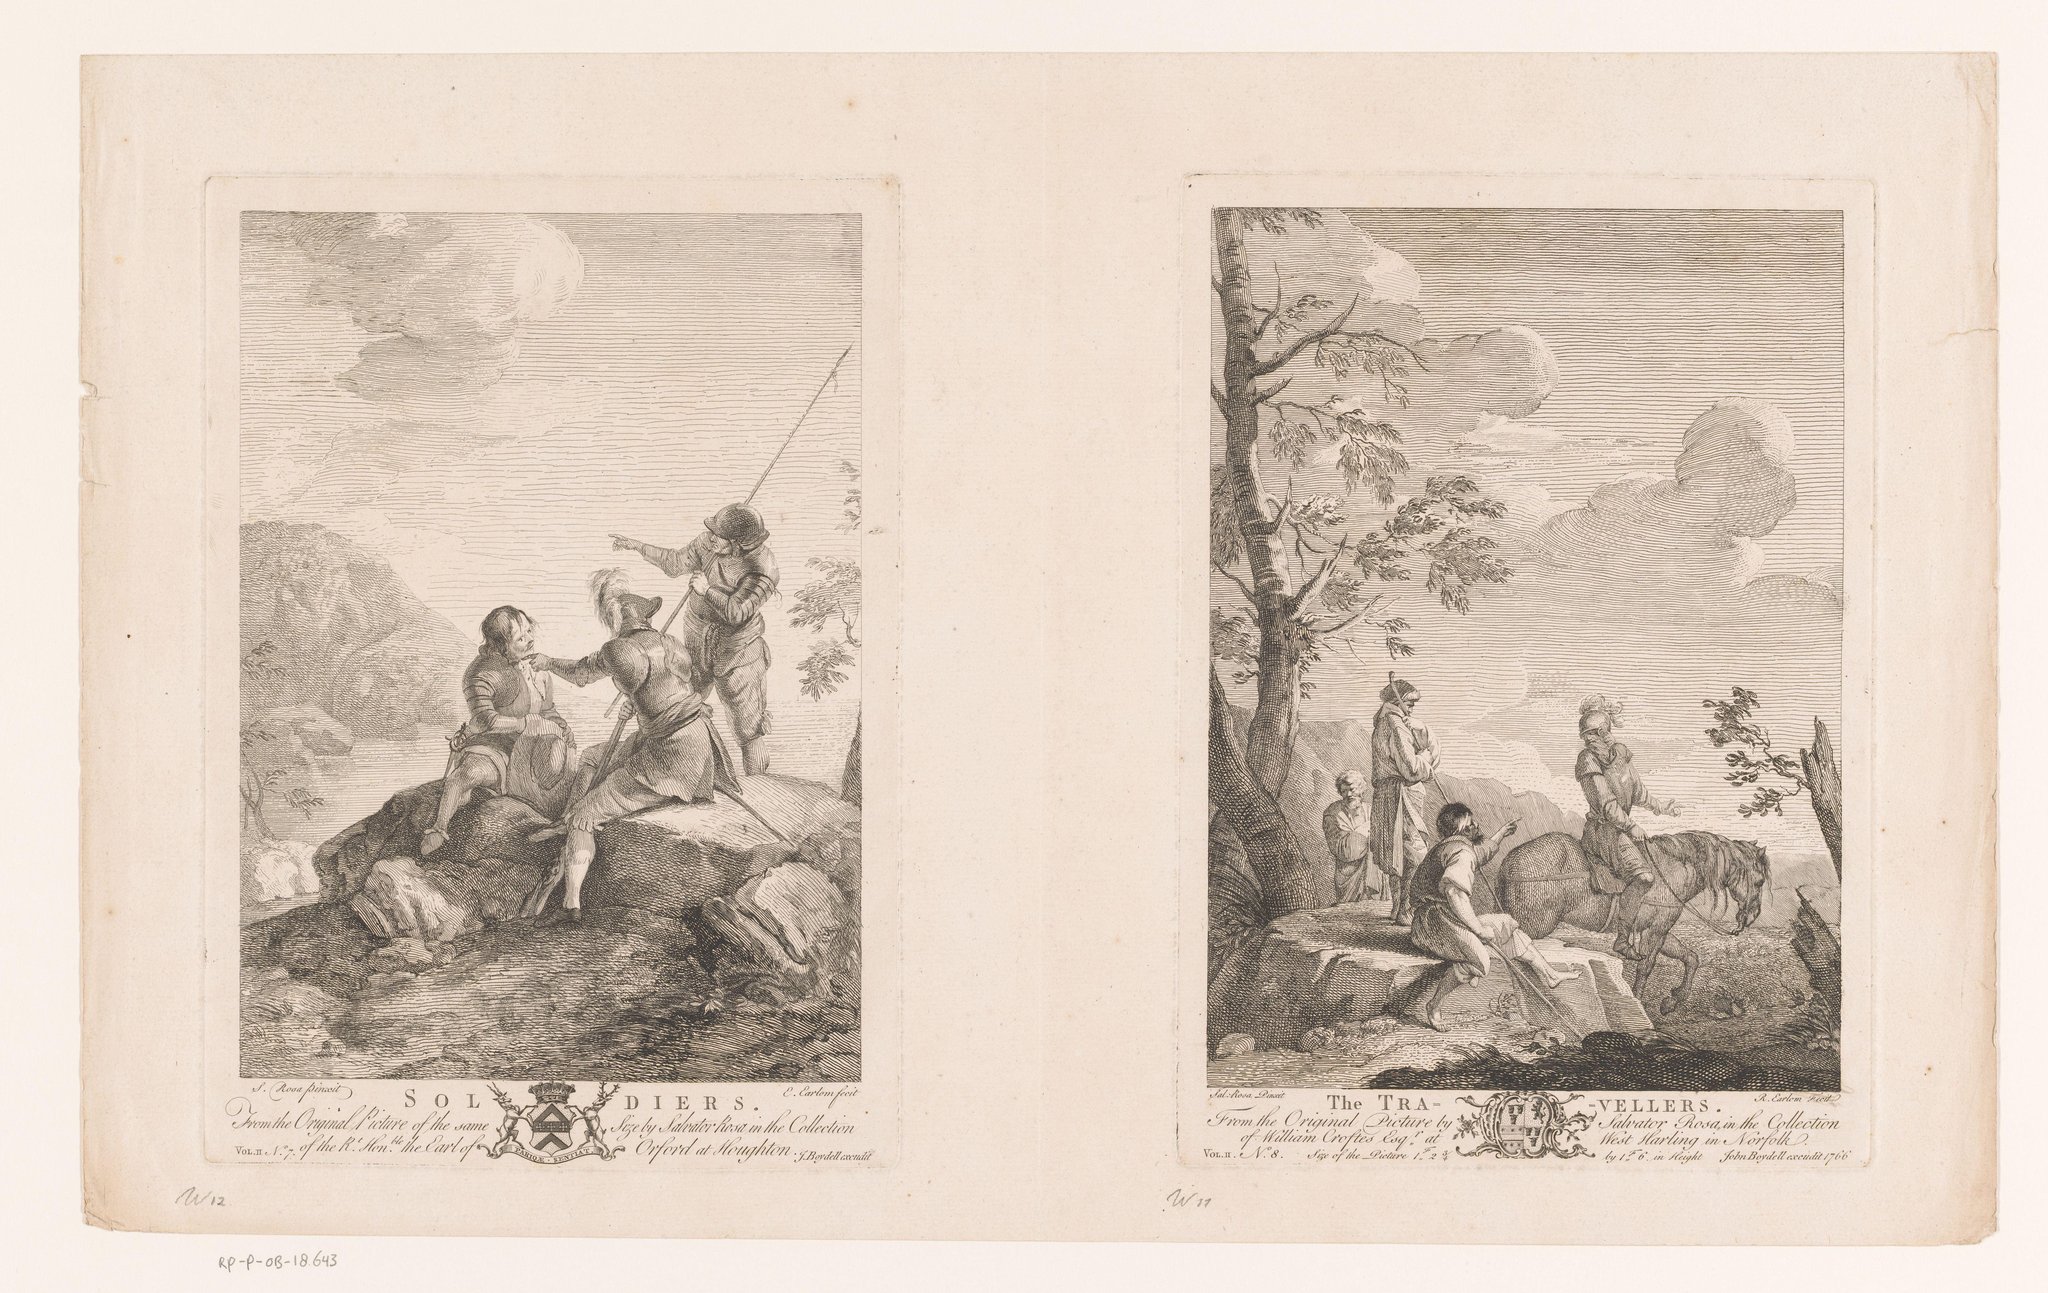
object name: print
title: Soldiers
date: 1766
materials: paper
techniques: etching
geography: london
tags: riding a horse, ass, or mule; rider, horseman, arm raised upward (+ indicating, pointing at), rocky coast, the soldier; the soldier's life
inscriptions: collector's mark: Lugt 2228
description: Prenten horen mogelijk bij de serie 'The Most Capital Paintings in England'.